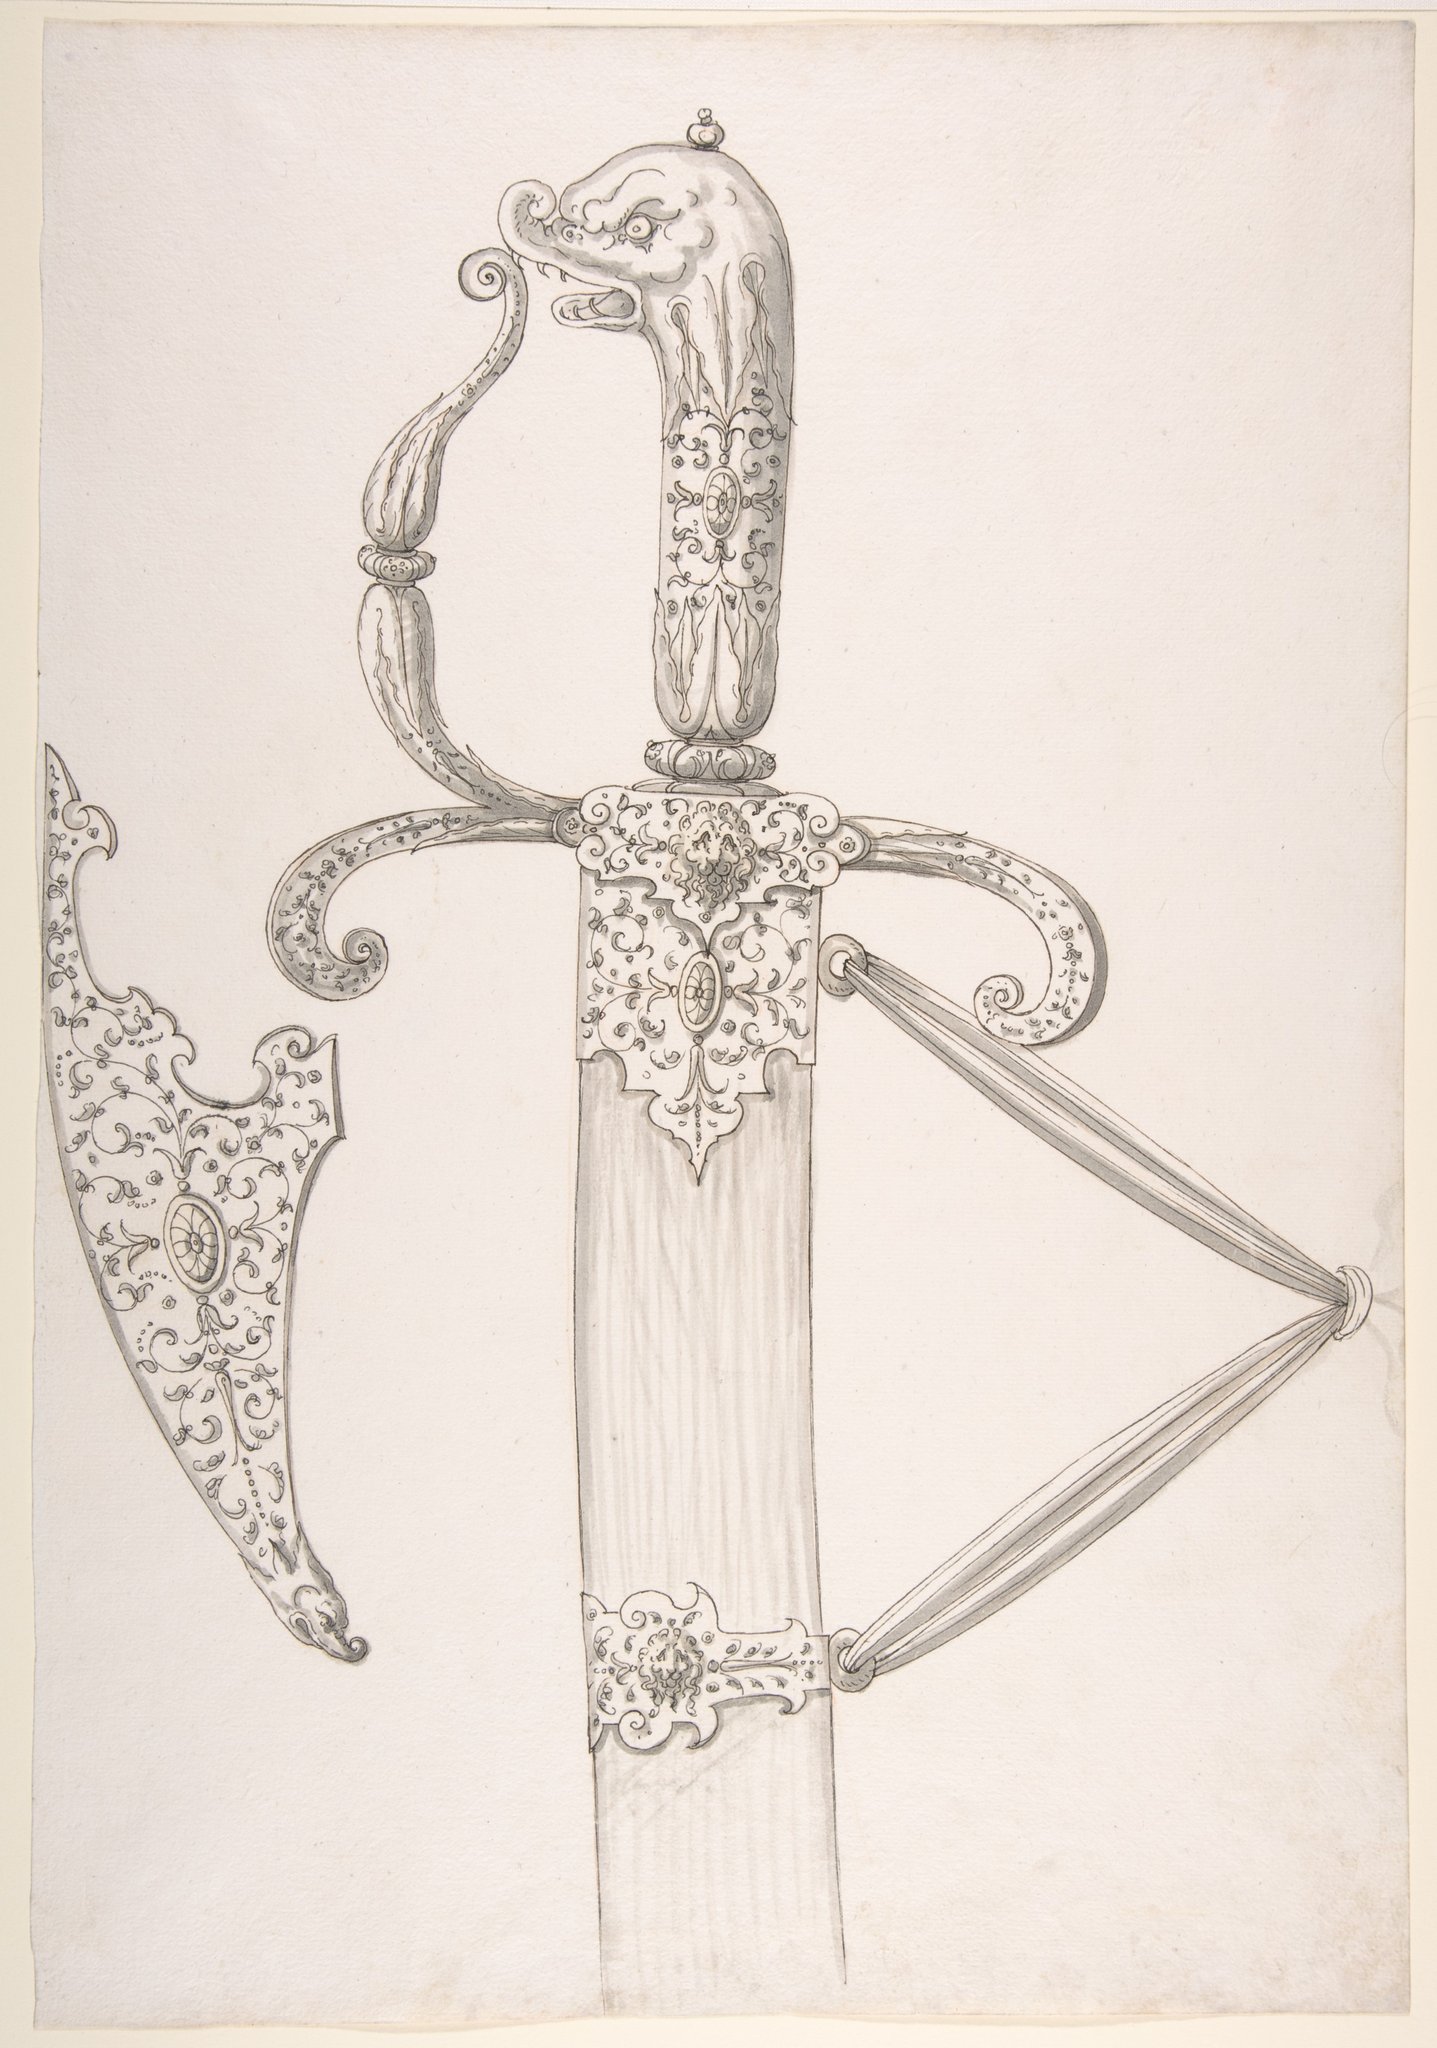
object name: drawing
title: Drawing of Design for Sword Hilt and Tip of Scabbard (Dolphin-Head Grip)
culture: german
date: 1551-1600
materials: ink, paper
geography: germany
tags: hilts